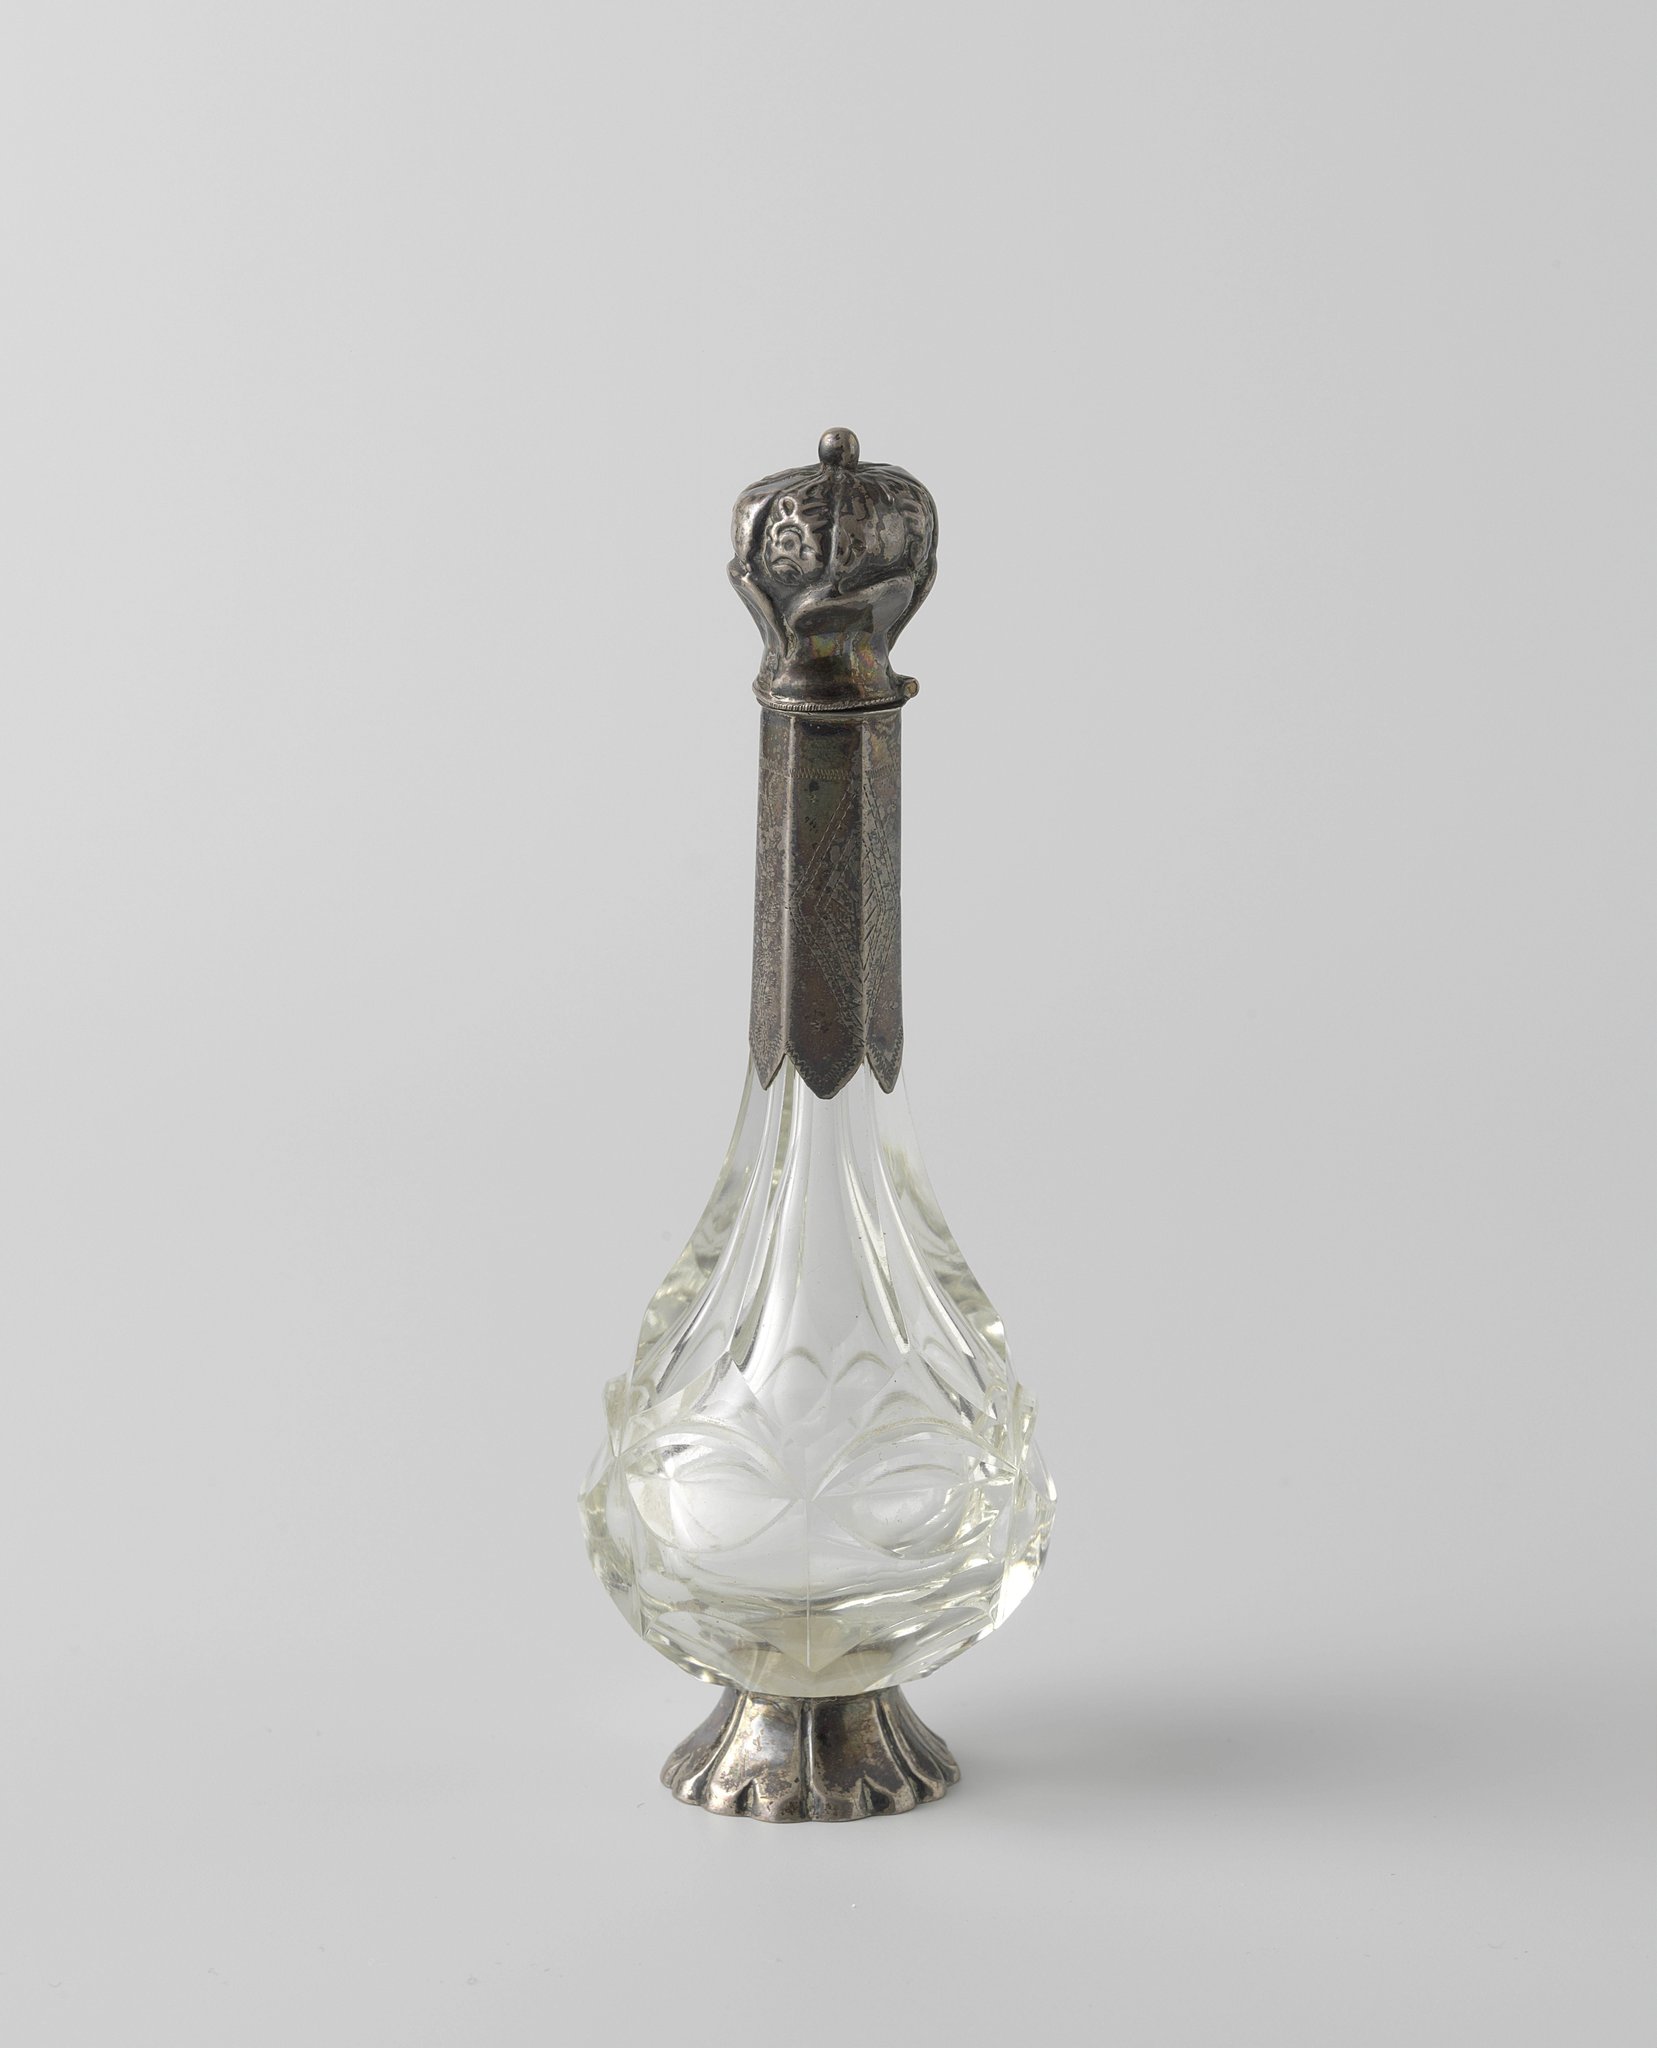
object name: bottle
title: Reukfles van zeszijdig geslepen kristal met montuur, voet en dop van zilver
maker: Anonymous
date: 1855-1865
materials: crystal, silver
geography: schoonhoven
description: Reukfles van zeszijdig geslepen kristal; bolle buik en hoge slanke hals, op licht gewelfde voet van zilver met gelobde onderrand en afwisselend hoge en lage inkepingen. De hals heeft een montuur van zilver met gegraveerde geometrische motieven, hierop is de dop bevestigd die bestaat uit een uit bladeren oprijzende gelobde bol en die wordt bekroond door een ronde knop. Deuk in dop. Nederland, ca. 1860.